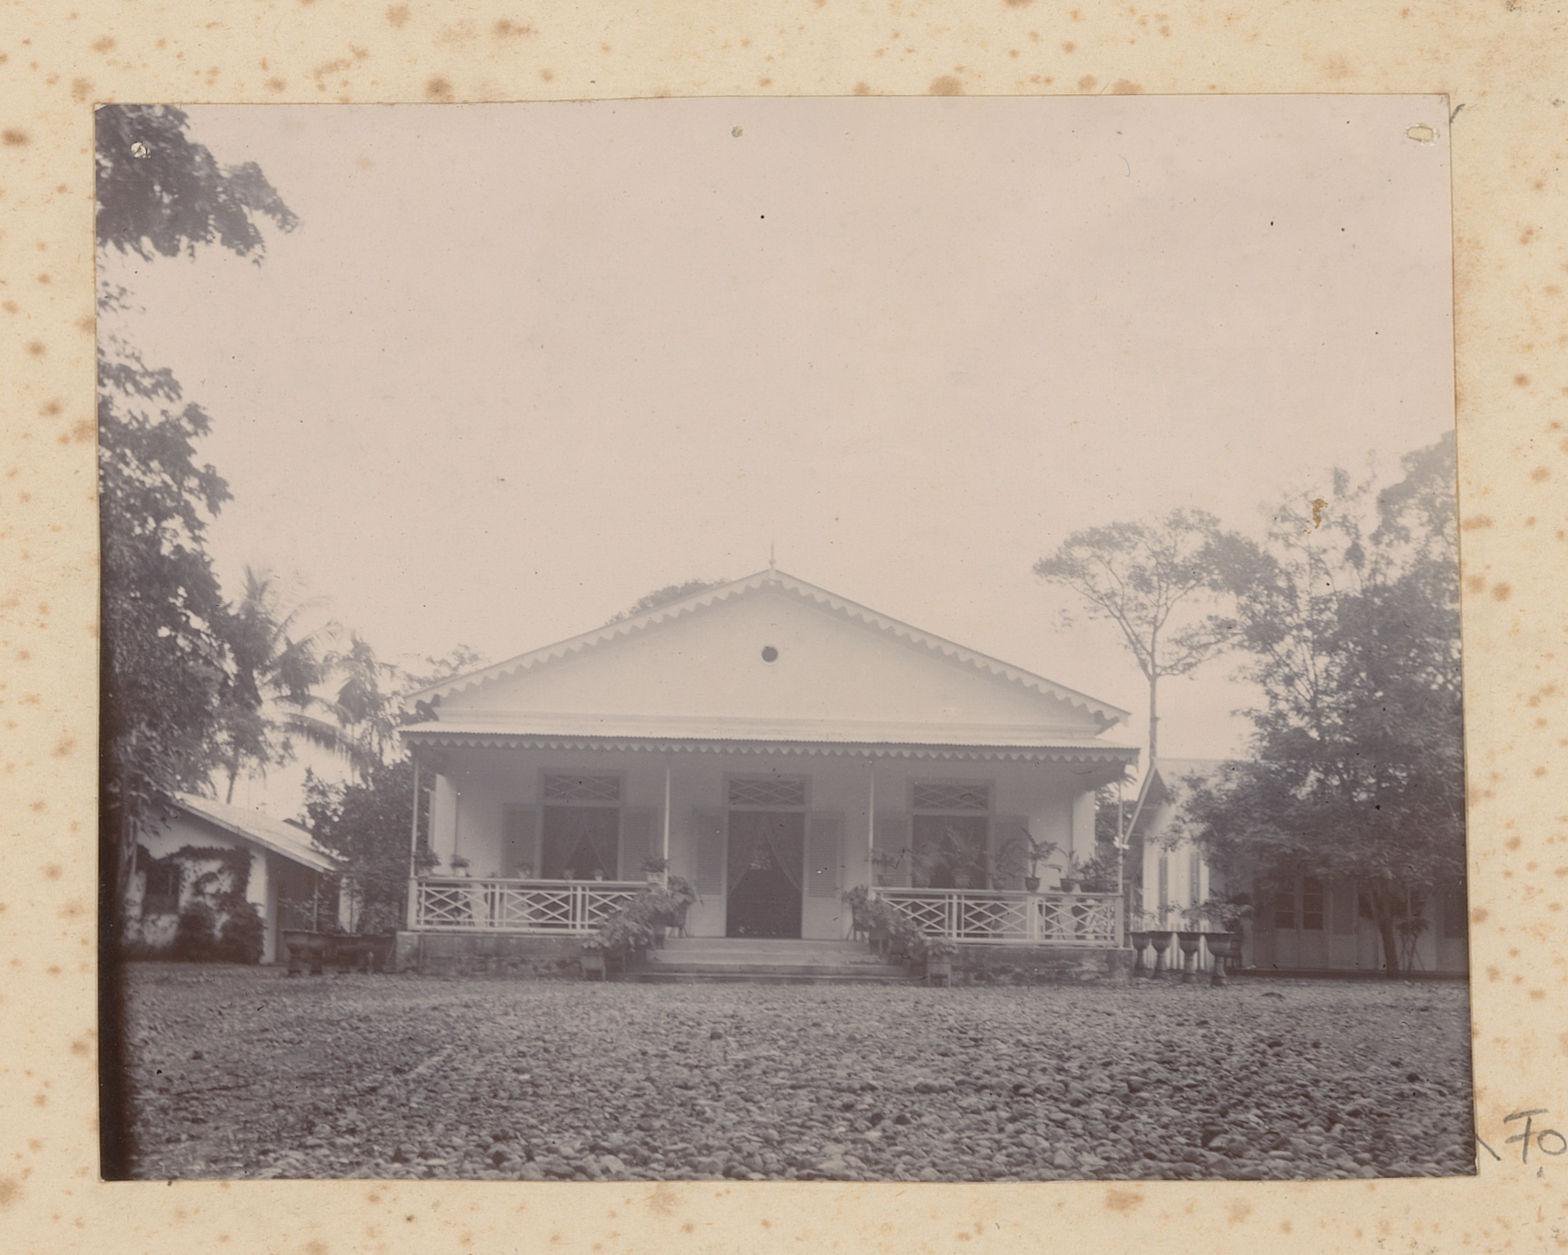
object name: album leaf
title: Gezicht op een woning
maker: Anonymous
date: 1890-1910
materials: photographic support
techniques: collodion silver print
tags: rural housing, e.g. country-house, villa, cottage, dutch east indies, the